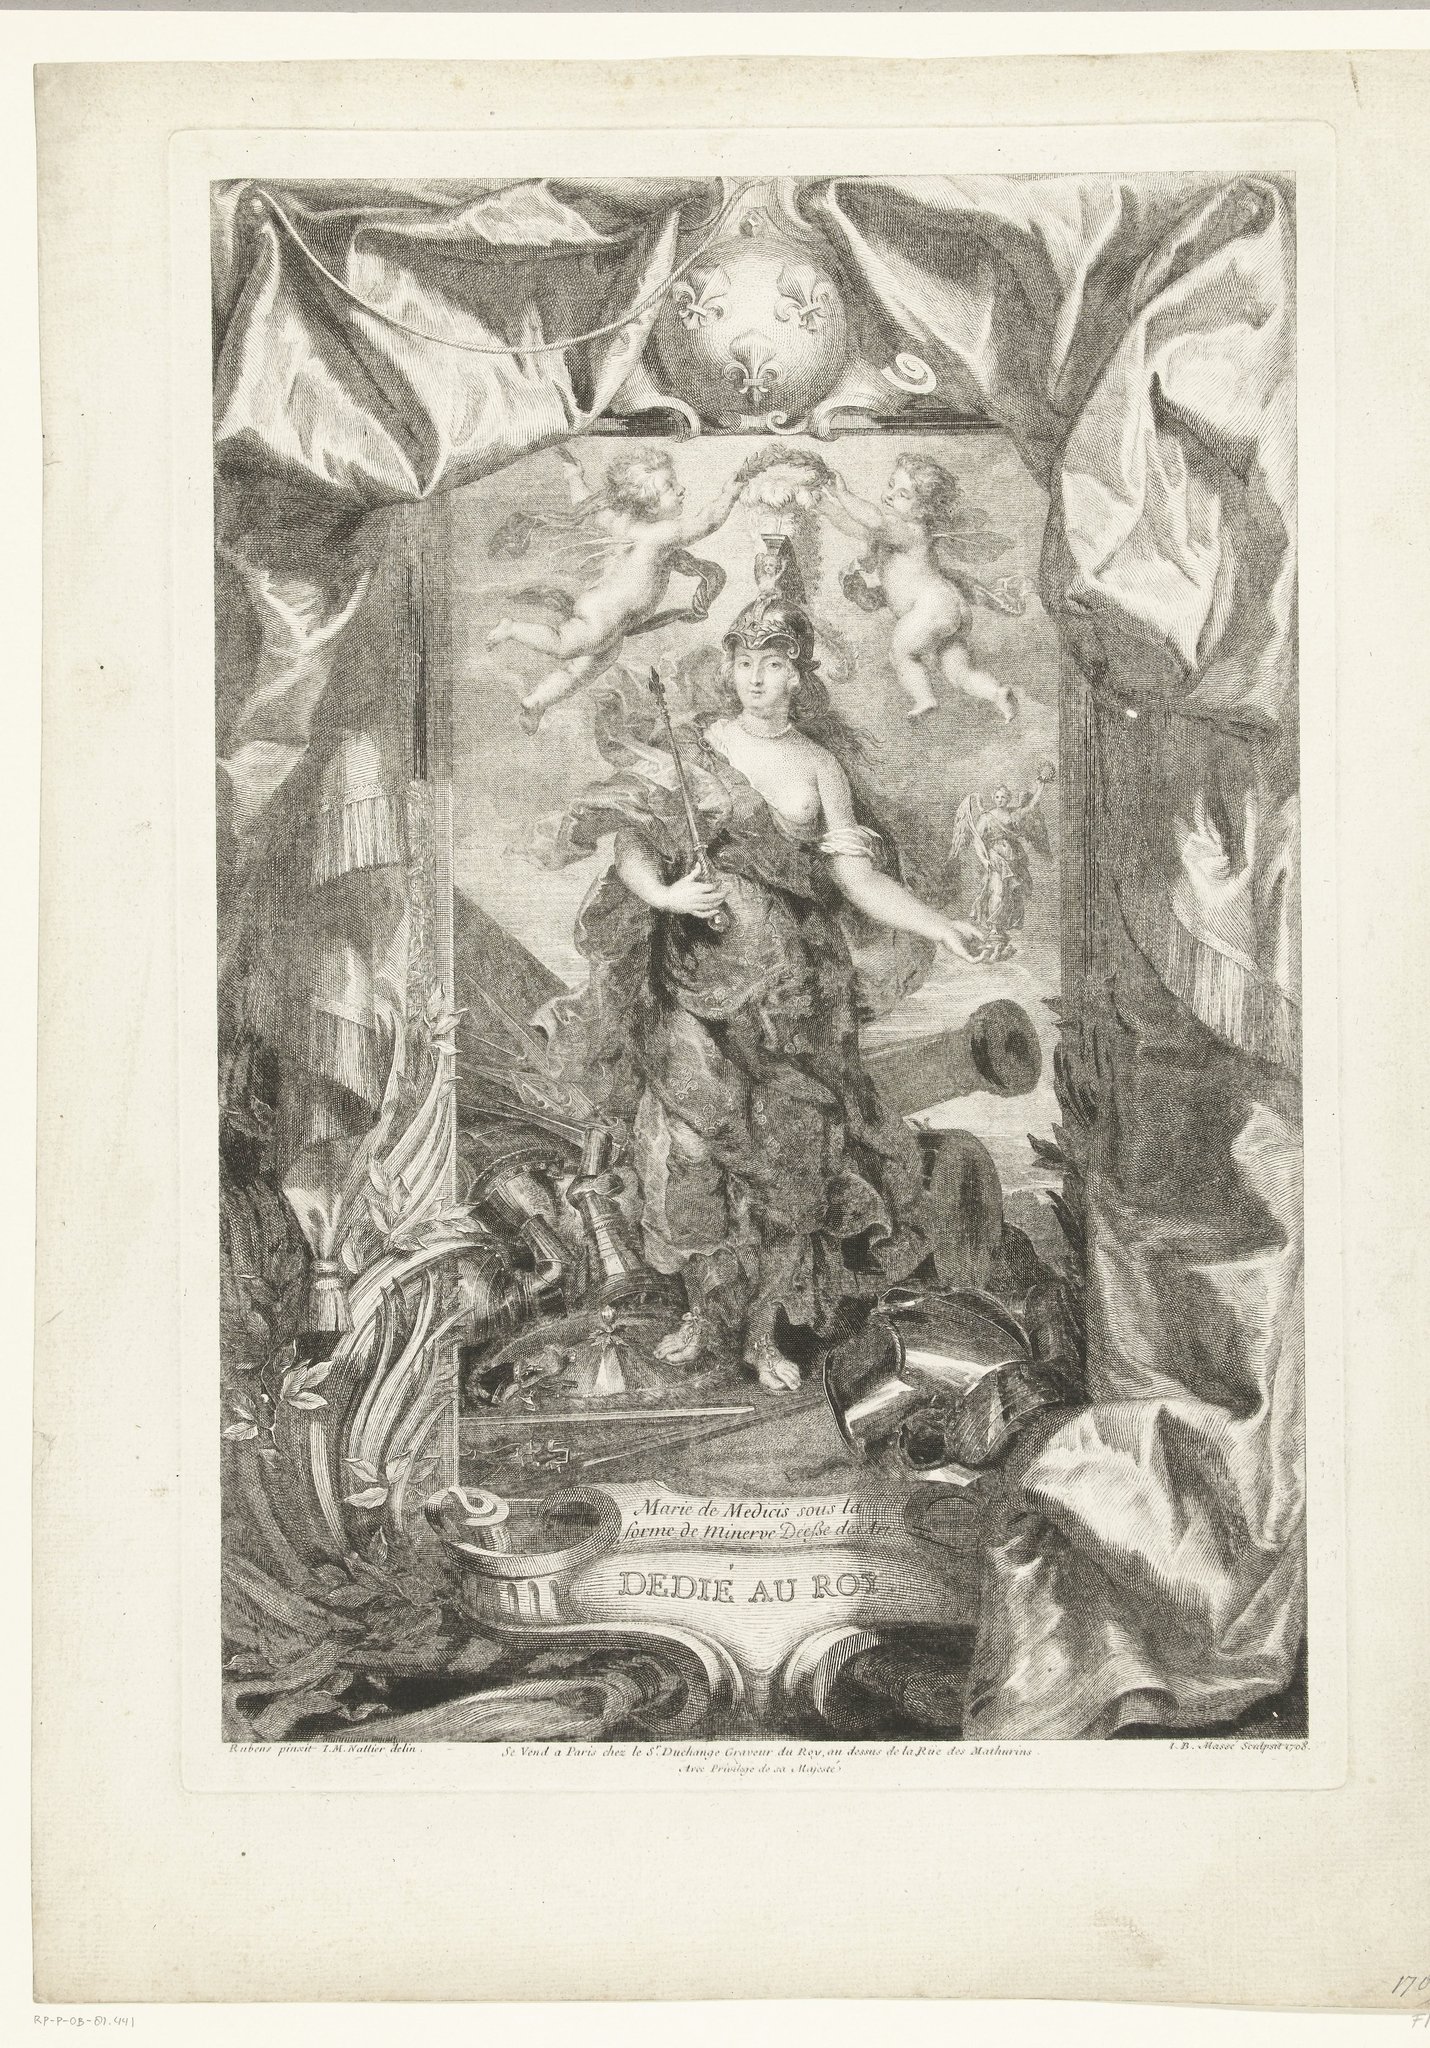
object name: print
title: Maria de Médicis als Minerva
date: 1708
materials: paper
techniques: engraving, etching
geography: france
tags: cologne, print maker, maria de' medici, historical persons (portraits and scenes from the life) (+ all kinds of 'portrait historié': mythological portrait, allegorical portrait, 'rollenporträt', etc.), specific aspects, allegorical aspects of minerva; minerva as patroness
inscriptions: date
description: Allegorisch portret van de Frans koningin Maria de Médicis als Minerva. Staande tussen wapens en delen van wapenrusting, in de linkerhand een beeldje van Victoria. Twee engelen kronen haar met een lauwerkrans. In lijst tussen gordijnen, bovenaan het wapen met de Franse lelies.